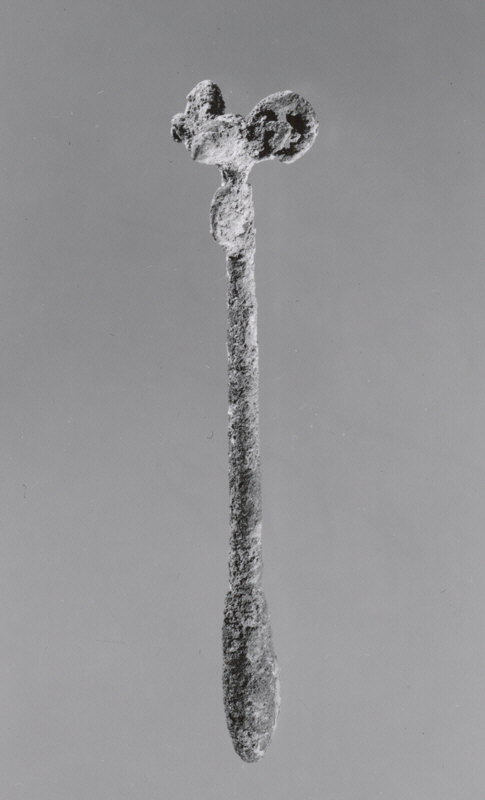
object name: implement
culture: bactria-margiana archaeological complex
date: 2333-1668 BCE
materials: copper alloy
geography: bactria-margiana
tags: rams